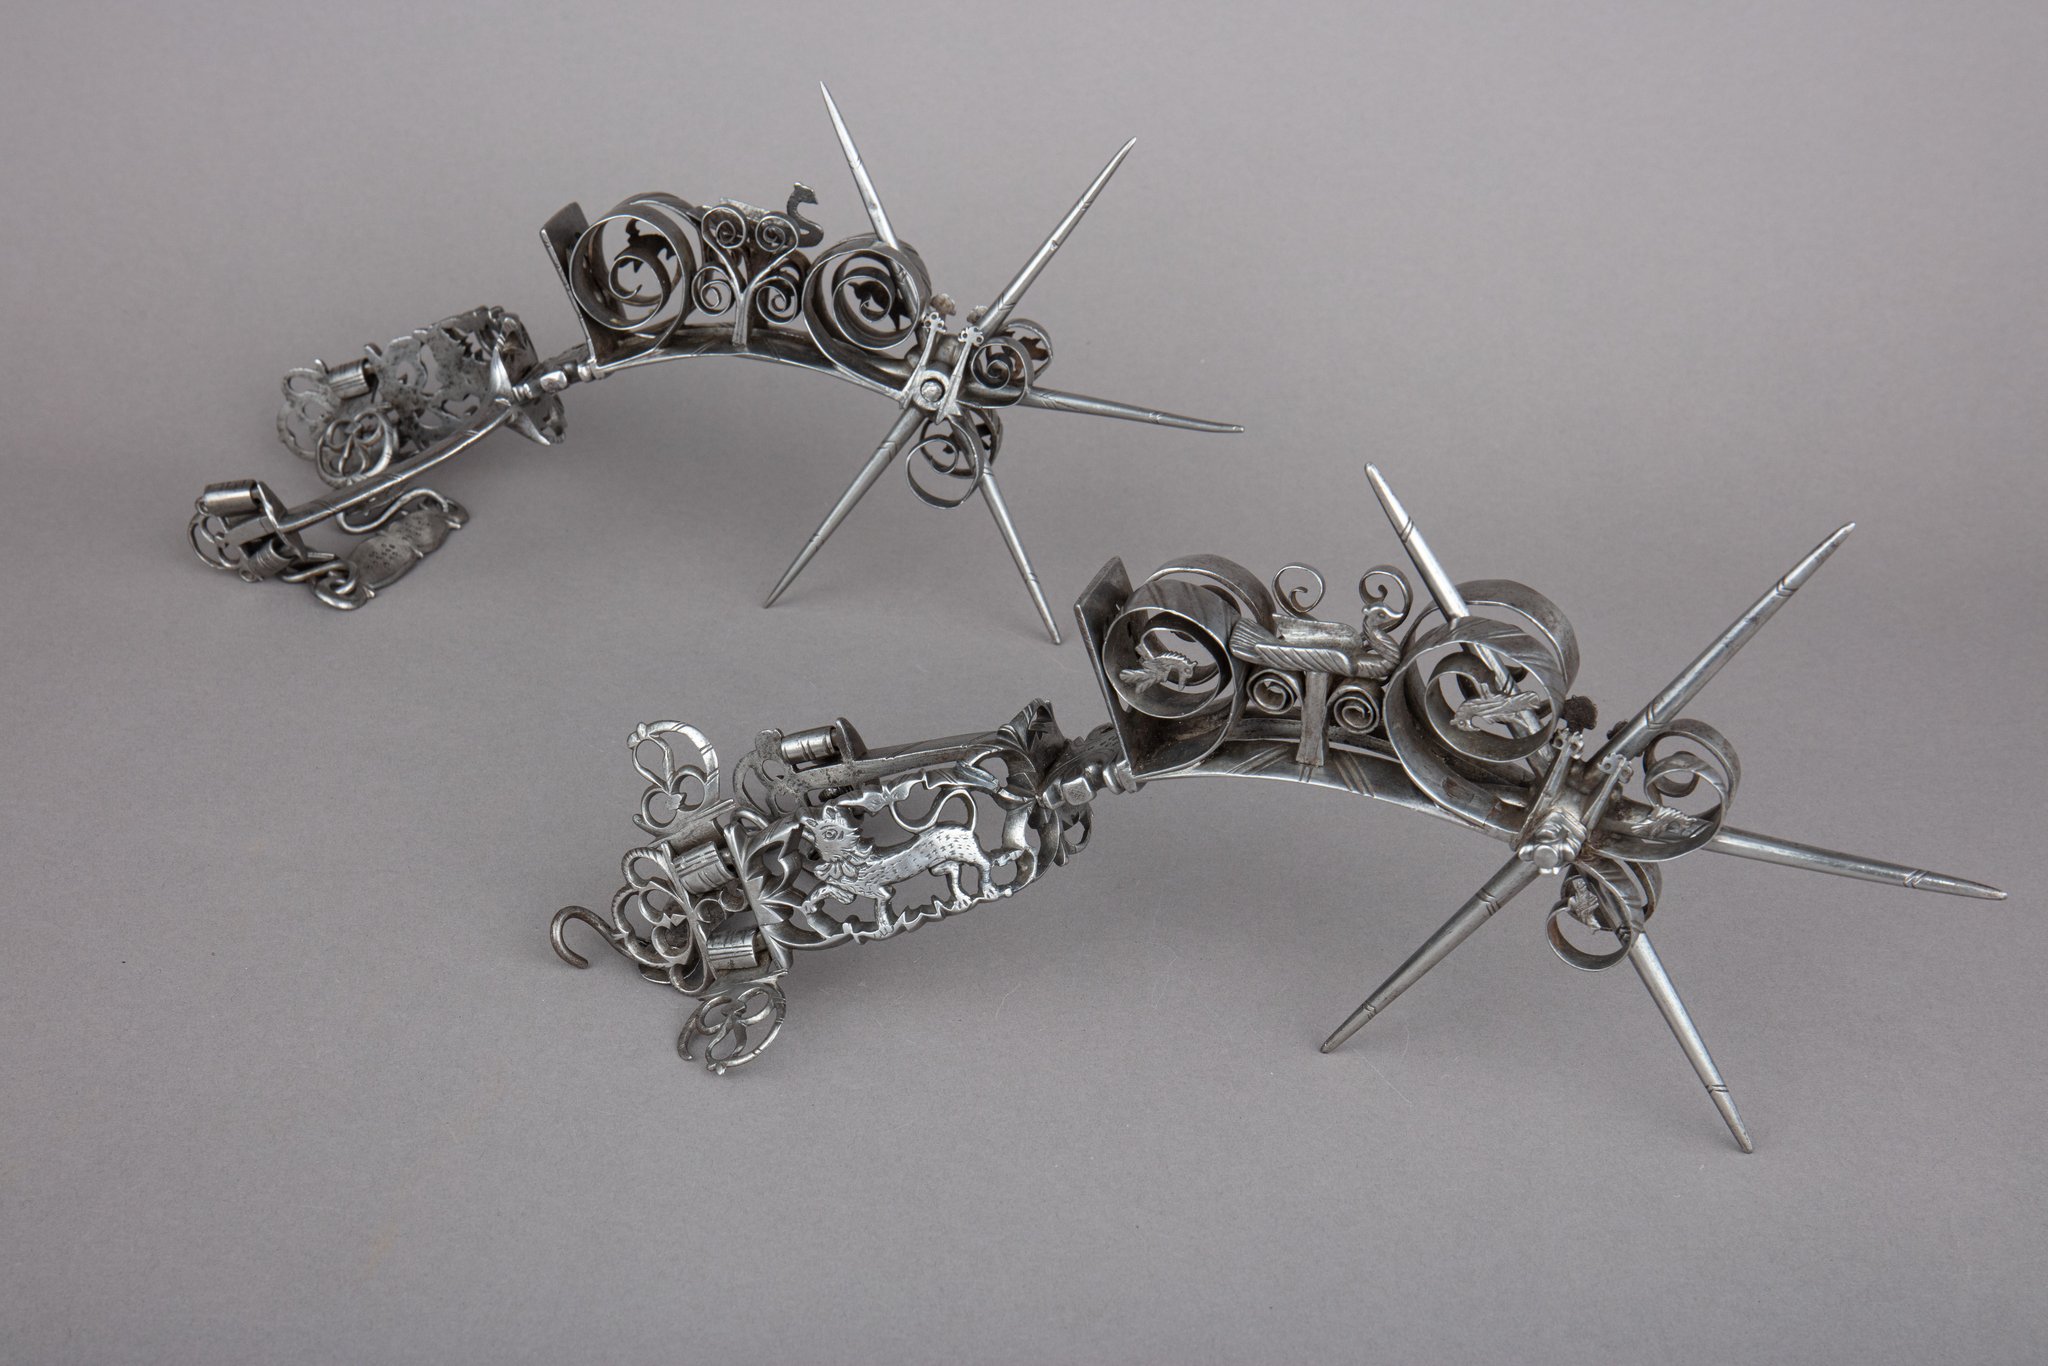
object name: spur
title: Pair of Rowel Spurs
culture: mexican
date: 1701-1750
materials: metal alloy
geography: mexico